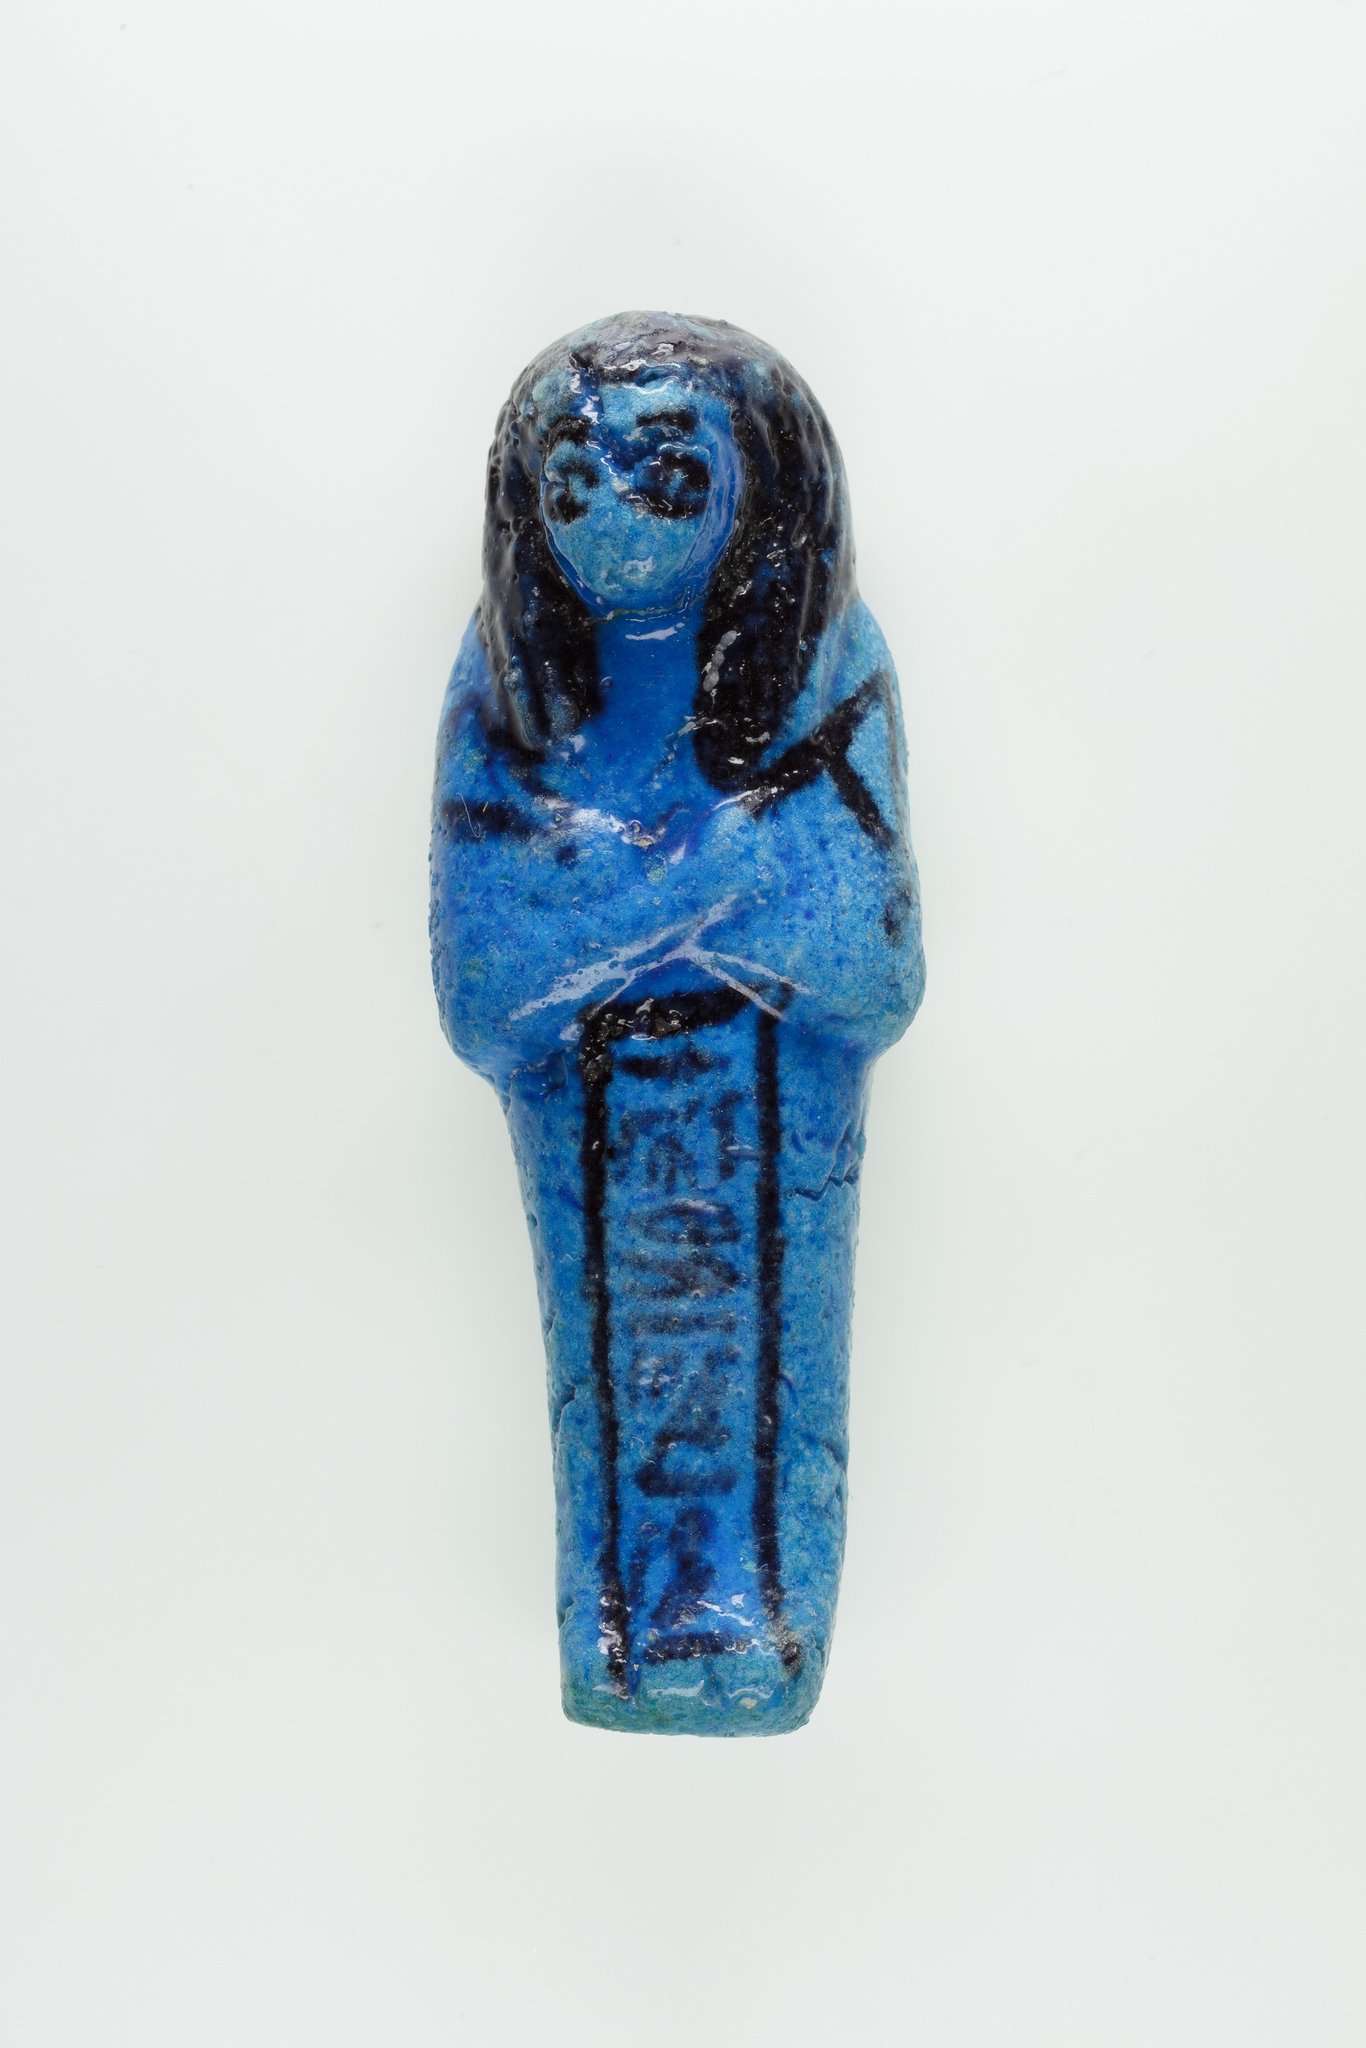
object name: shabti, worker, nauny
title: Worker Shabti of Nauny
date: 1050 BCE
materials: faience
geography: egypt